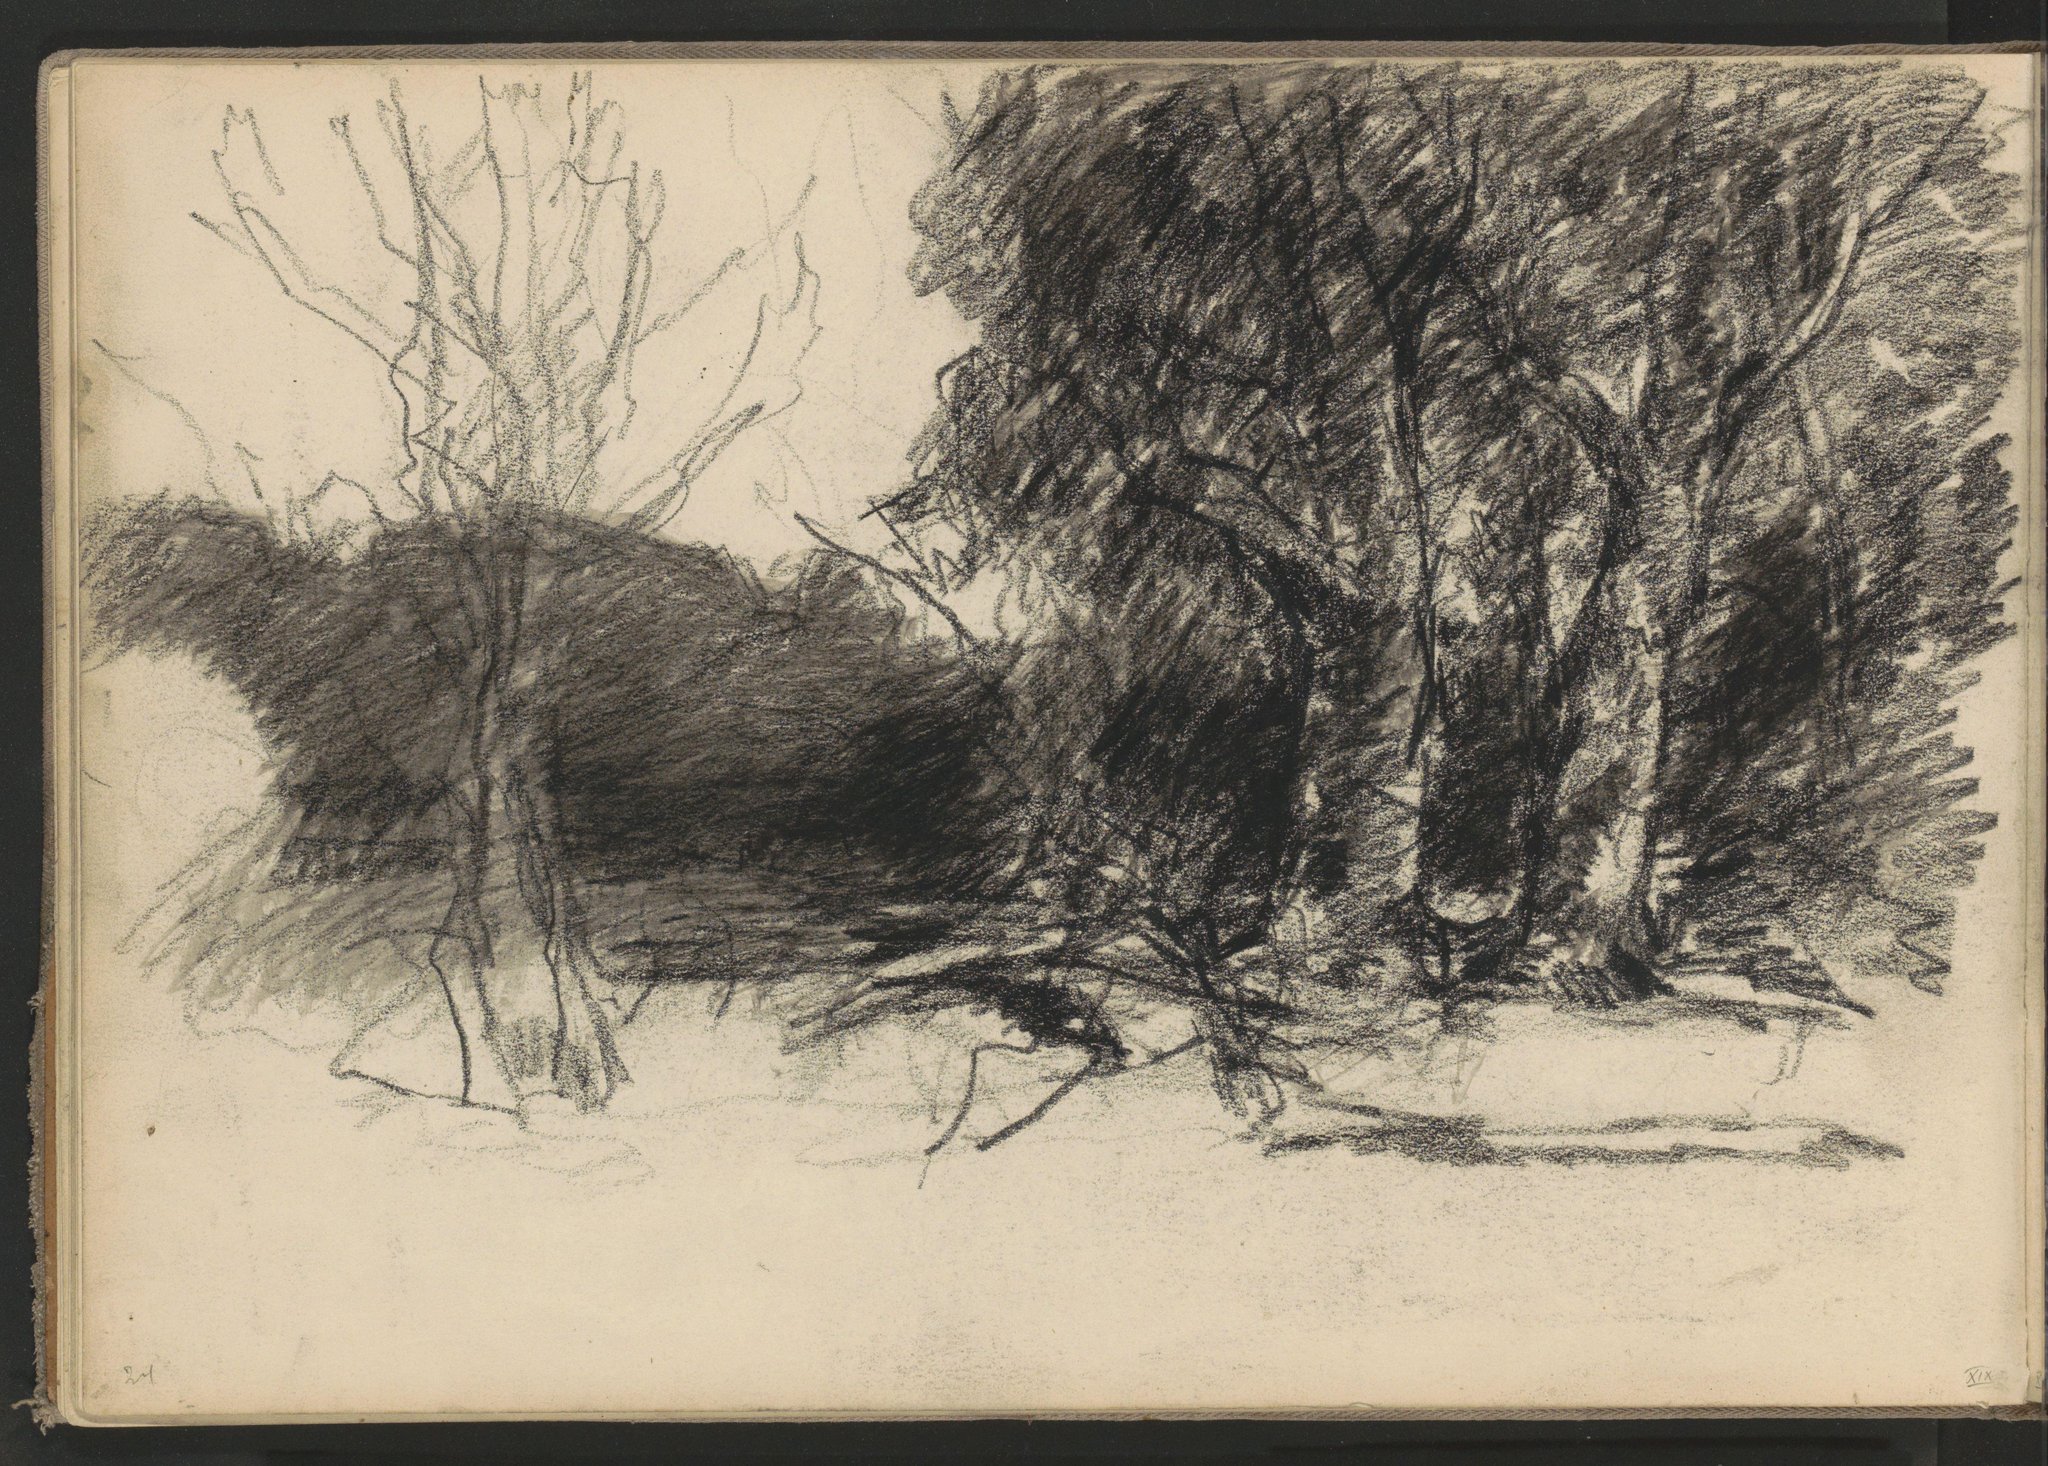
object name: sketchbook leaf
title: Bomen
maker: egbert rubertus derk schaap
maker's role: draughtsman, painter, print maker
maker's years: 1862-1939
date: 1891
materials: chalk, paper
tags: trees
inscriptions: number: ‘XIX’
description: Pagina 24 uit een schetsboek met 64 pagina's.